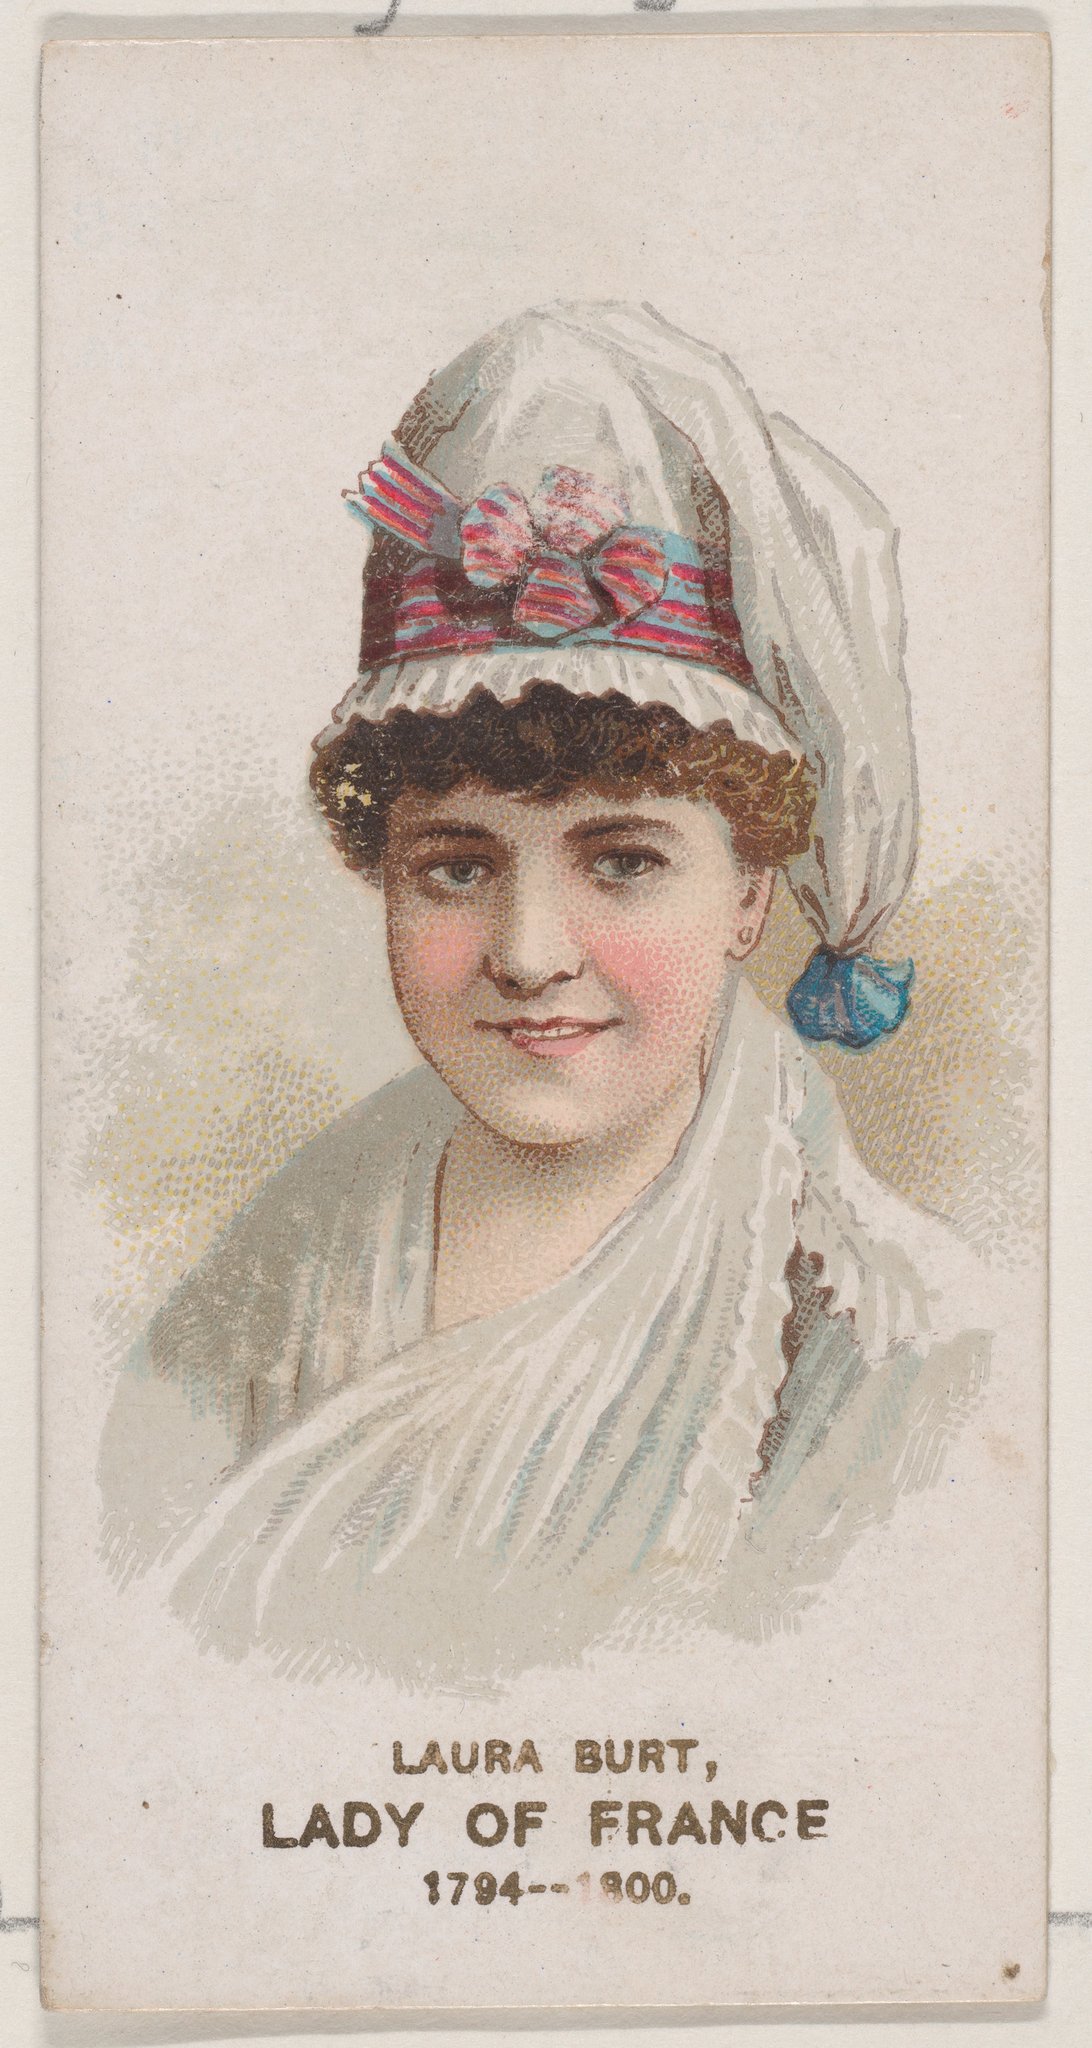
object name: print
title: Laura Burt as a Lady of France of 1794-1800, from the set Actors and Actresses, Second Series (N71) for Duke brand cigarettes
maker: w. duke, sons & co.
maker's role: publisher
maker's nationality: american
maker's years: 1870-1920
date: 1888-1890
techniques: color lithograph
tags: women,actresses